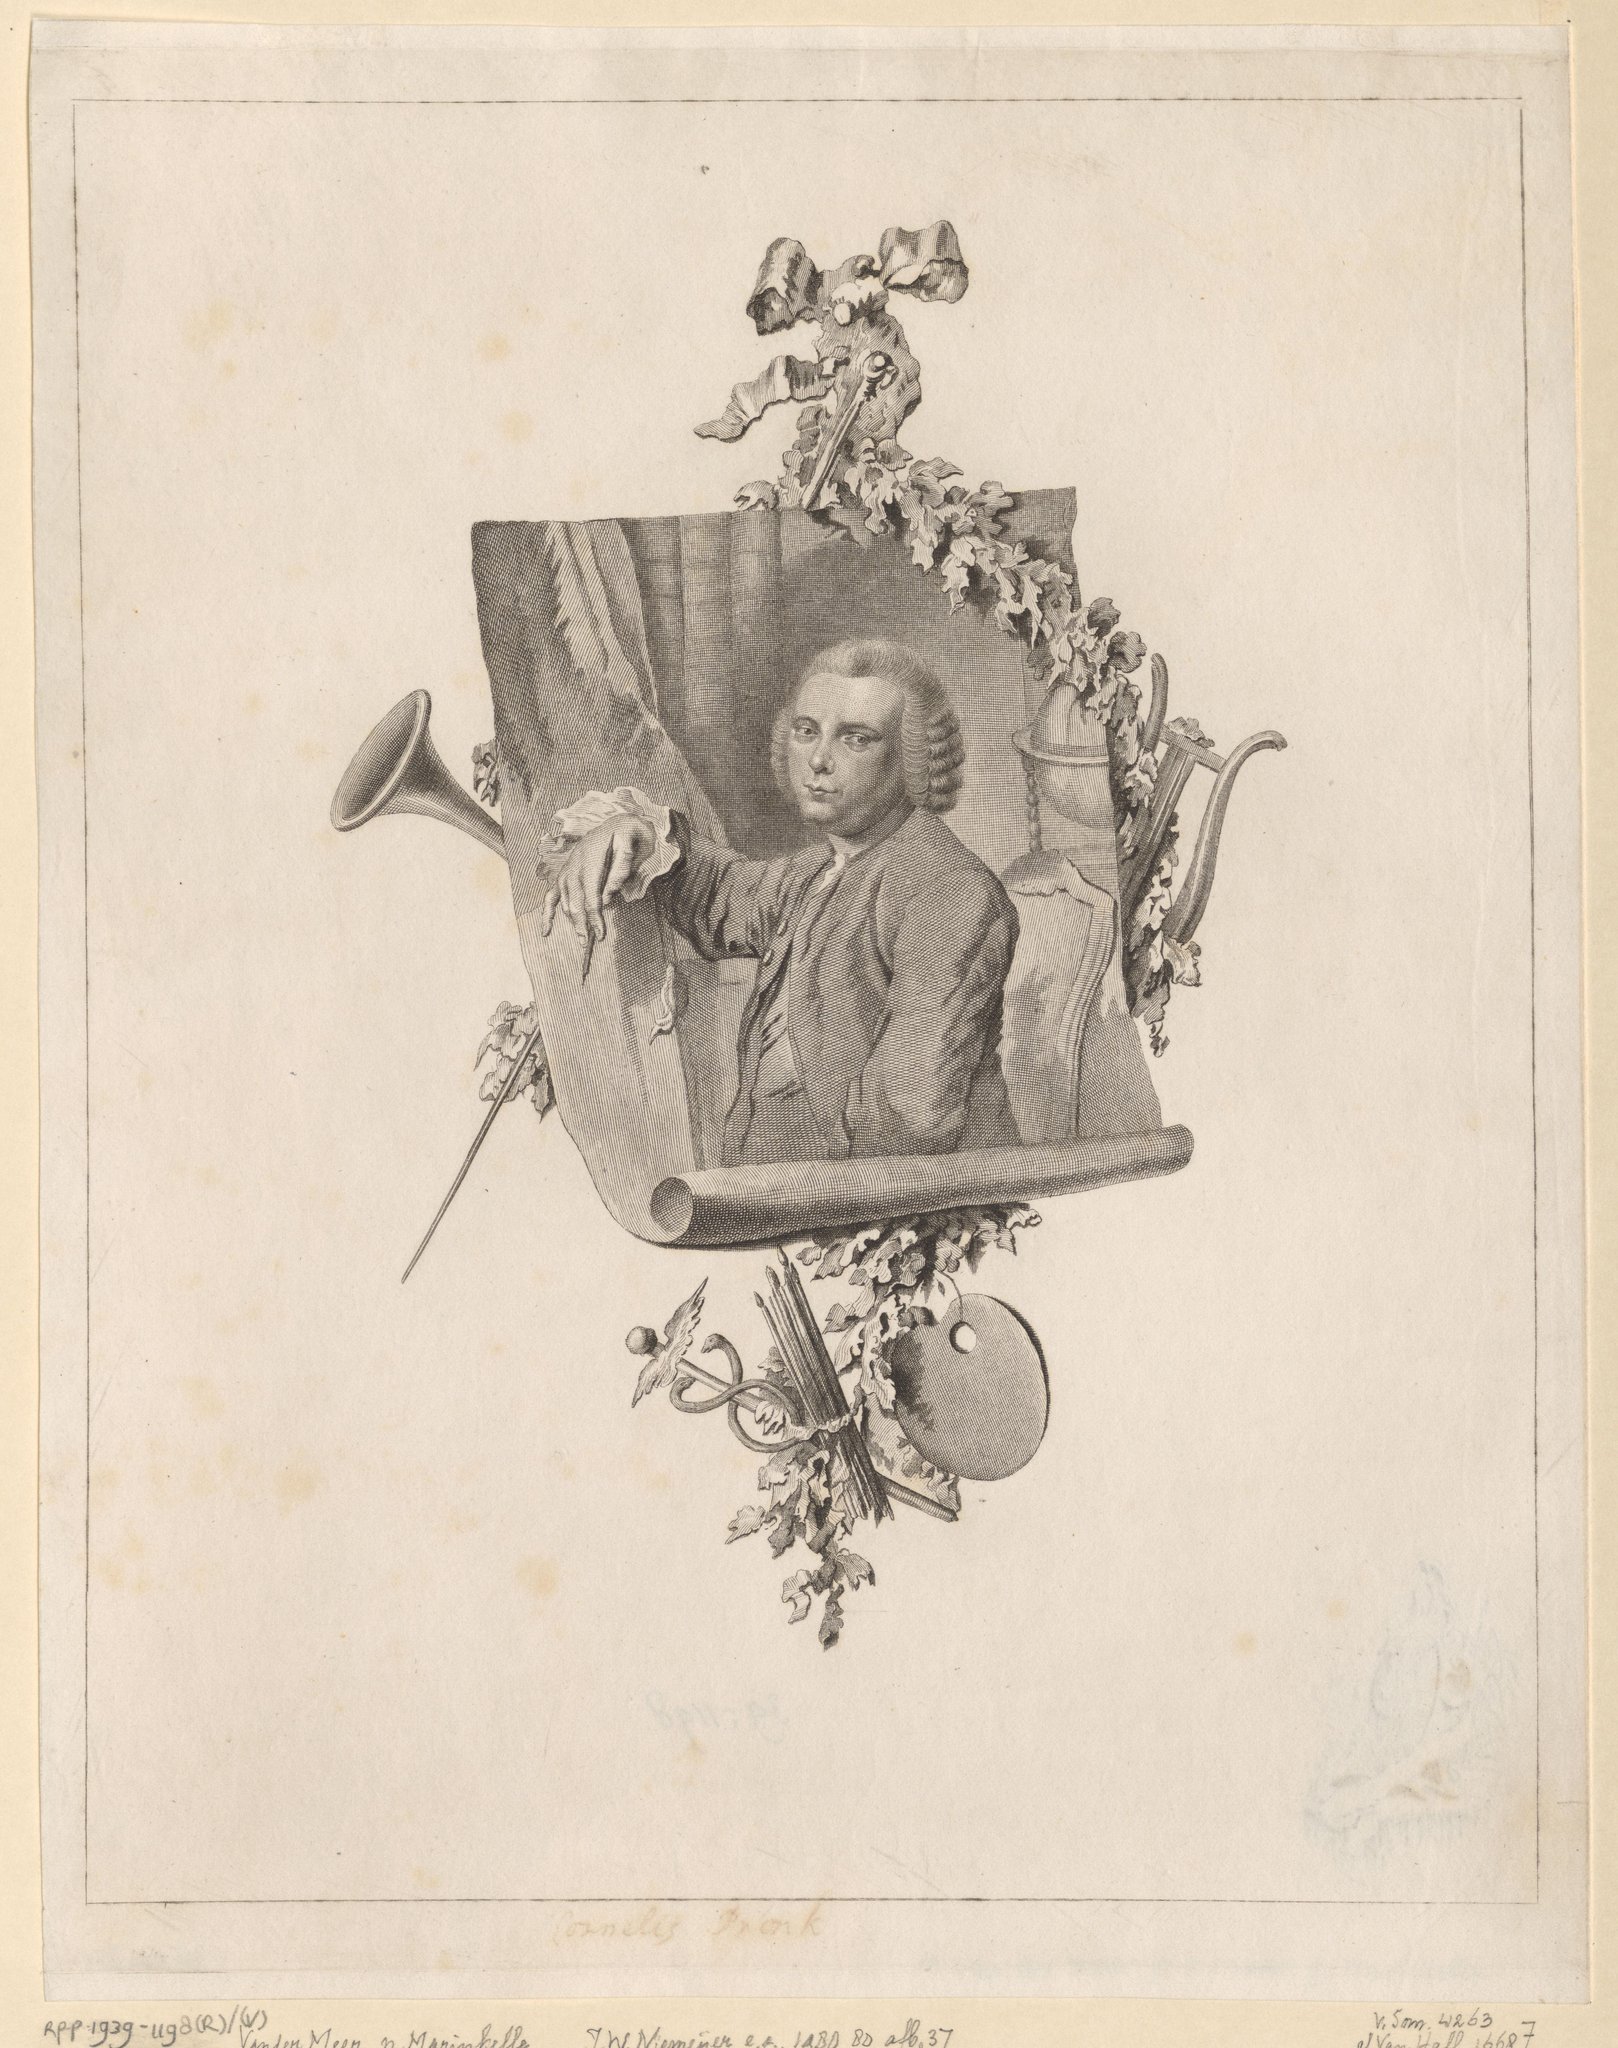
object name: print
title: Portret van Cornelis Ploos van Amstel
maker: noach van der meer (ii)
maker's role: draughtsman, print maker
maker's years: 1741-1822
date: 1751-1822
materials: paper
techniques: etching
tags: amsterdam, draughtsman, cornelis ploos van amstel, lyre, cithara, psaltery, adult man, historical persons, tools, implements of painter